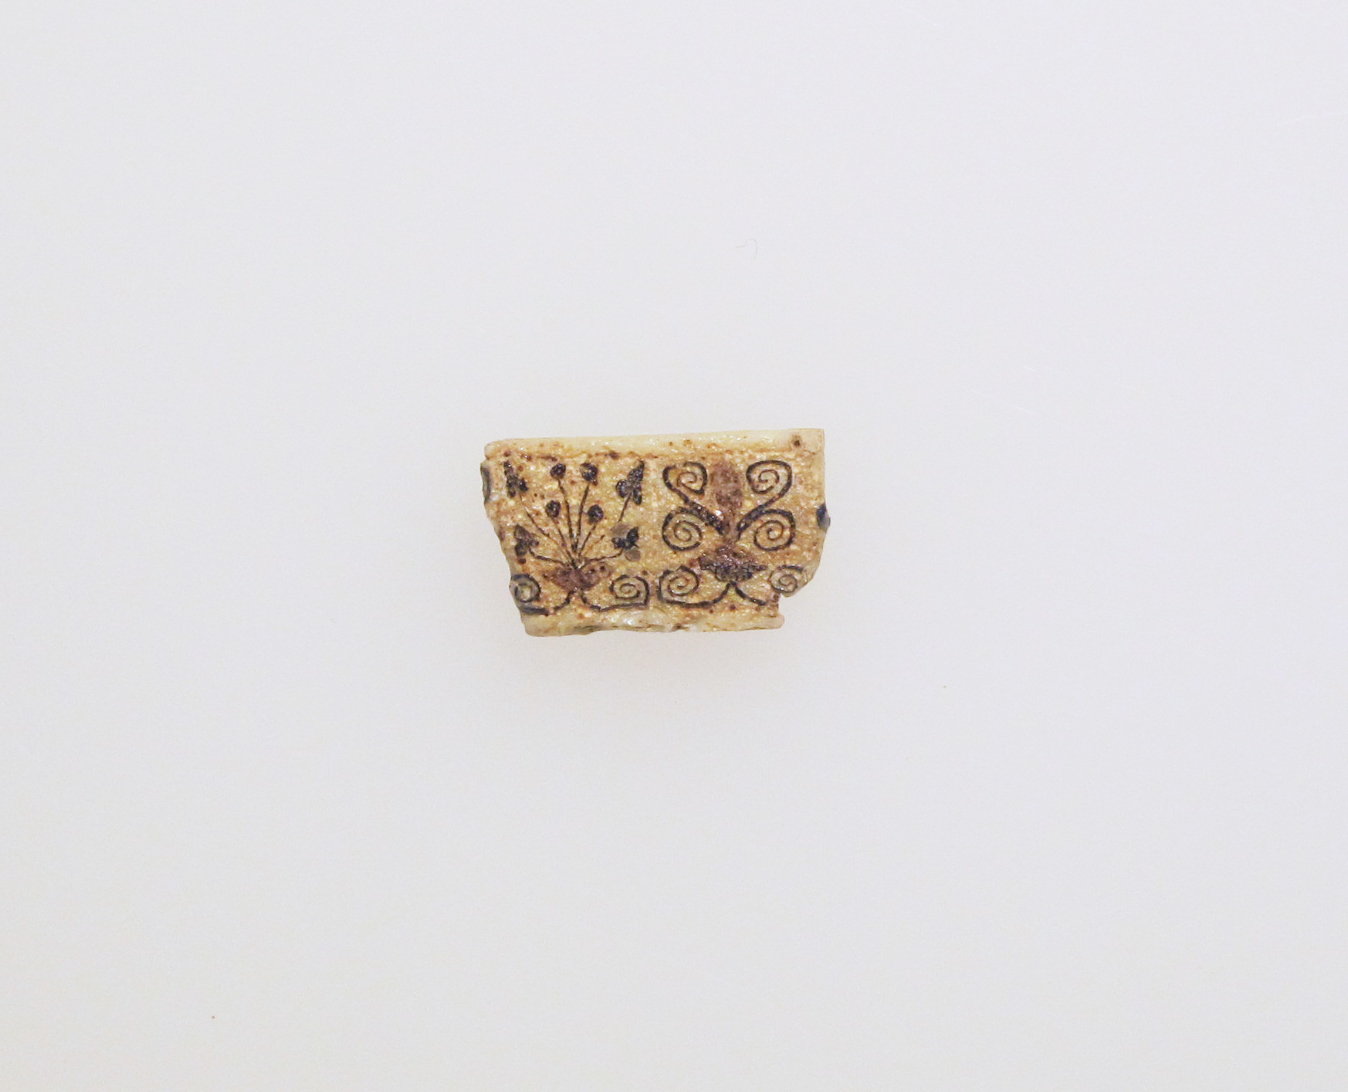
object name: mosaic block inlay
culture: roman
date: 34 BCE-100 CE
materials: glass